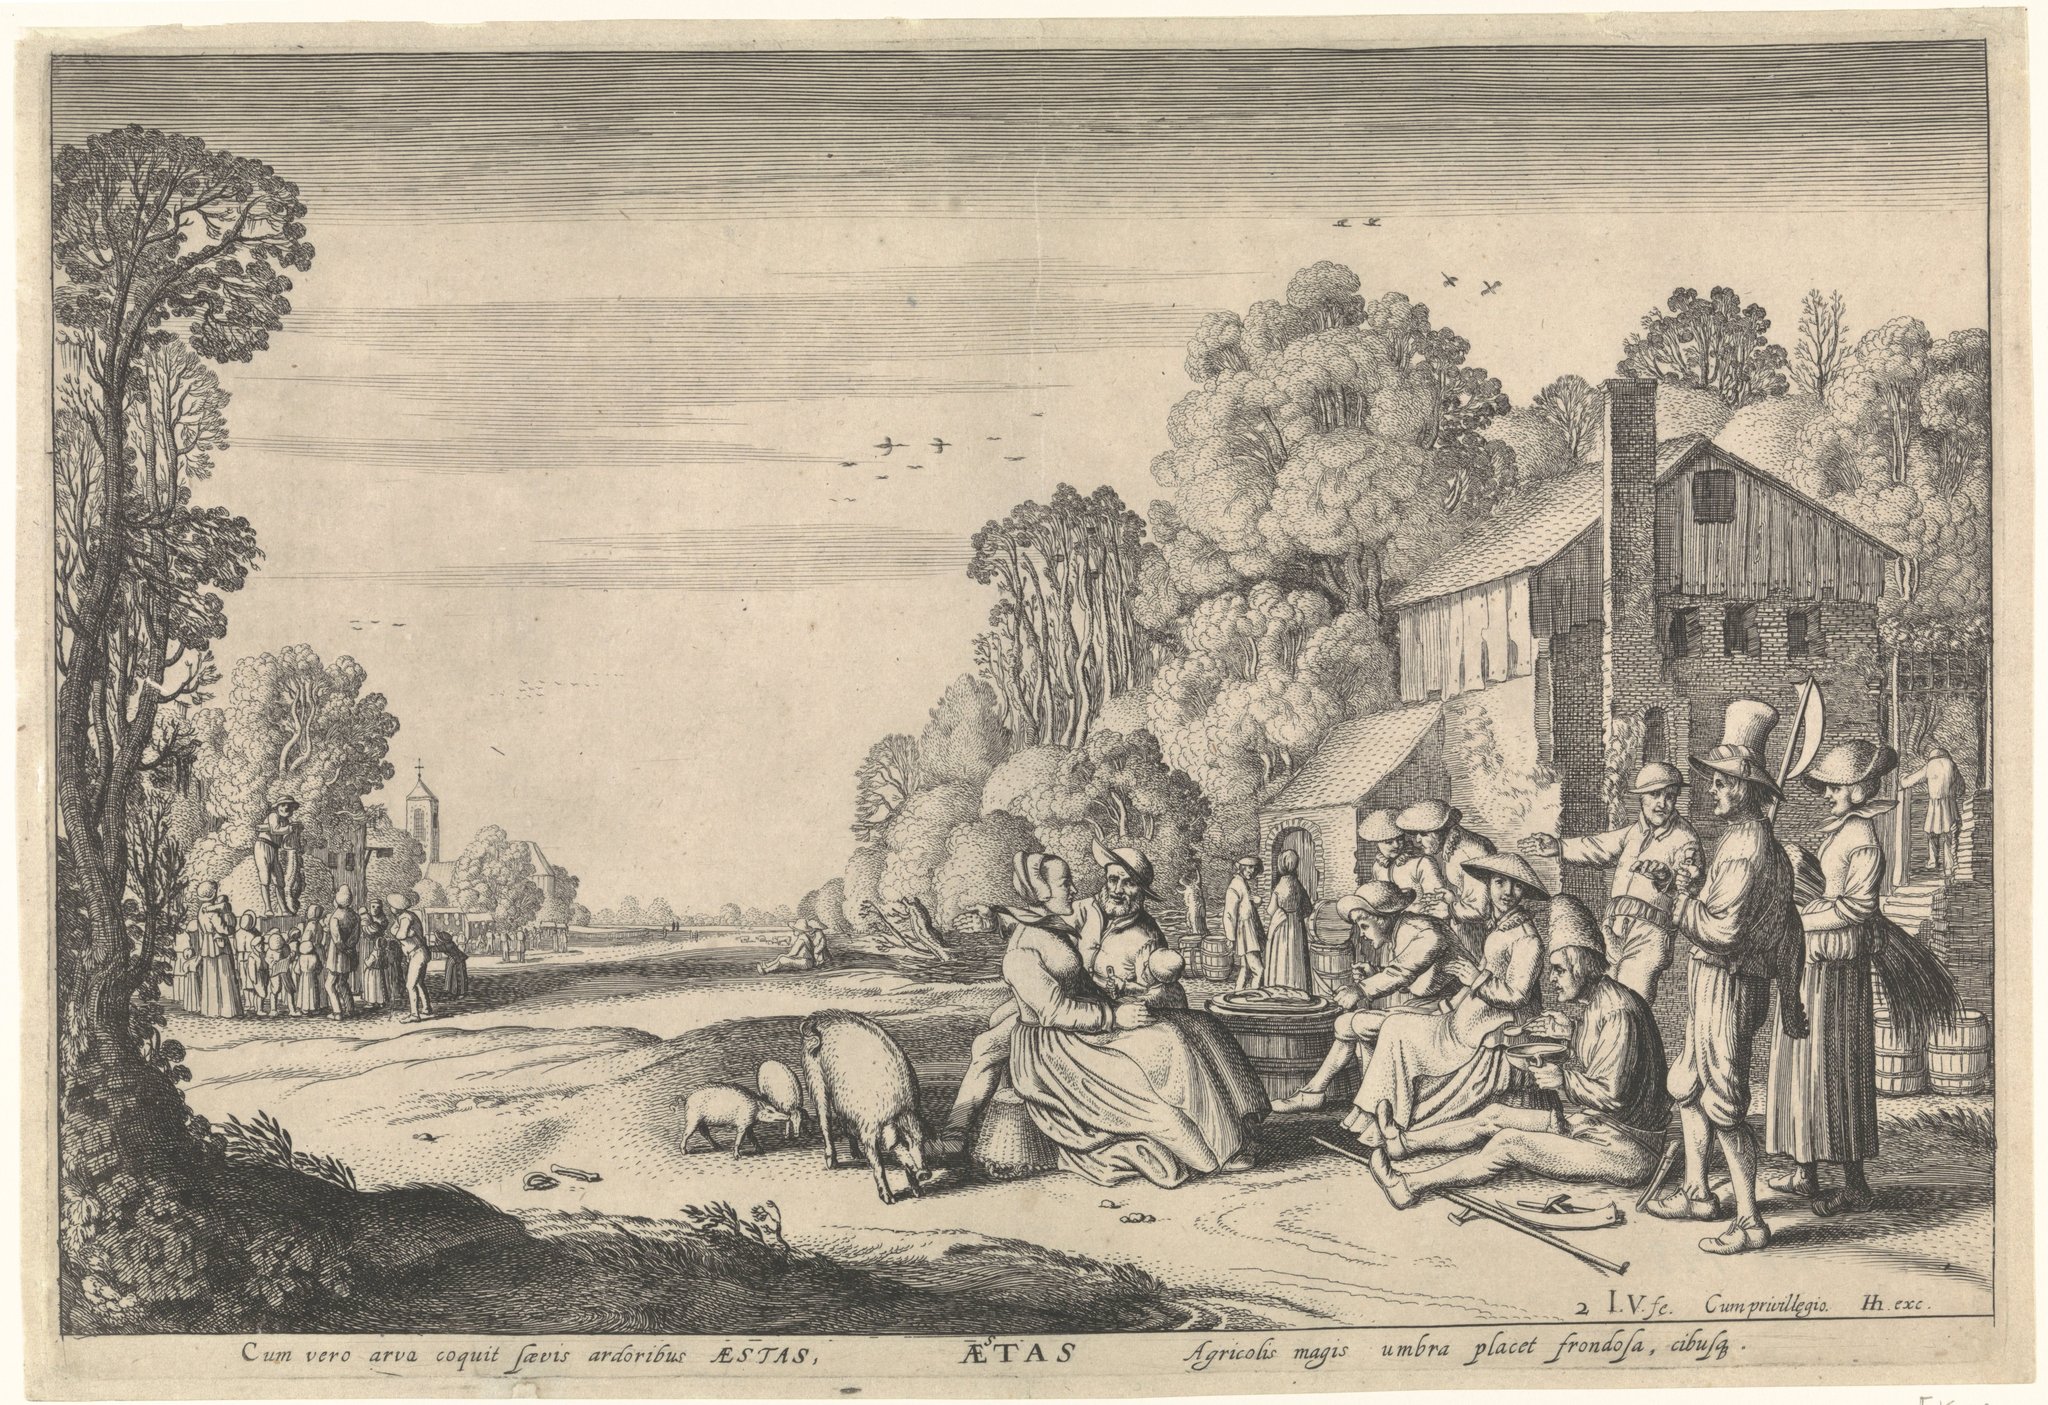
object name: print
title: De vier seizoenen A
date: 1617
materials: paper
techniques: engraving, etching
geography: northern netherlands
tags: summer, 'aestas'; 'estate' (ripa), summer landscape; landscape symbolizing summer (the four seasons of the year) (+ with scenes showing human occupations ~ seasons and months)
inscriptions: collector's mark: Lugt 240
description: Etende en converserende figuren en een vrouw met een zeis bij een huis. Links een man met een vel papier in de hand bij toehoorders op een verhoging. Verbeelding van het jaargetijde zomer, tweede prent van een serie van vier.